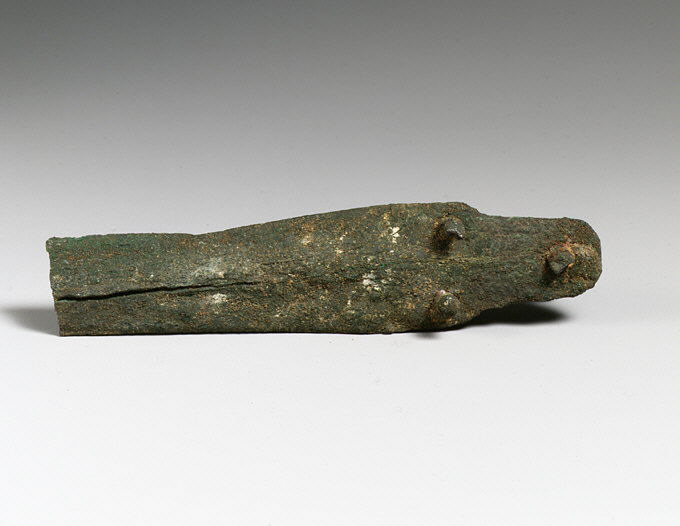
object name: dagger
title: Dagger blade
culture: cypriot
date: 3000-2000 BCE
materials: bronze